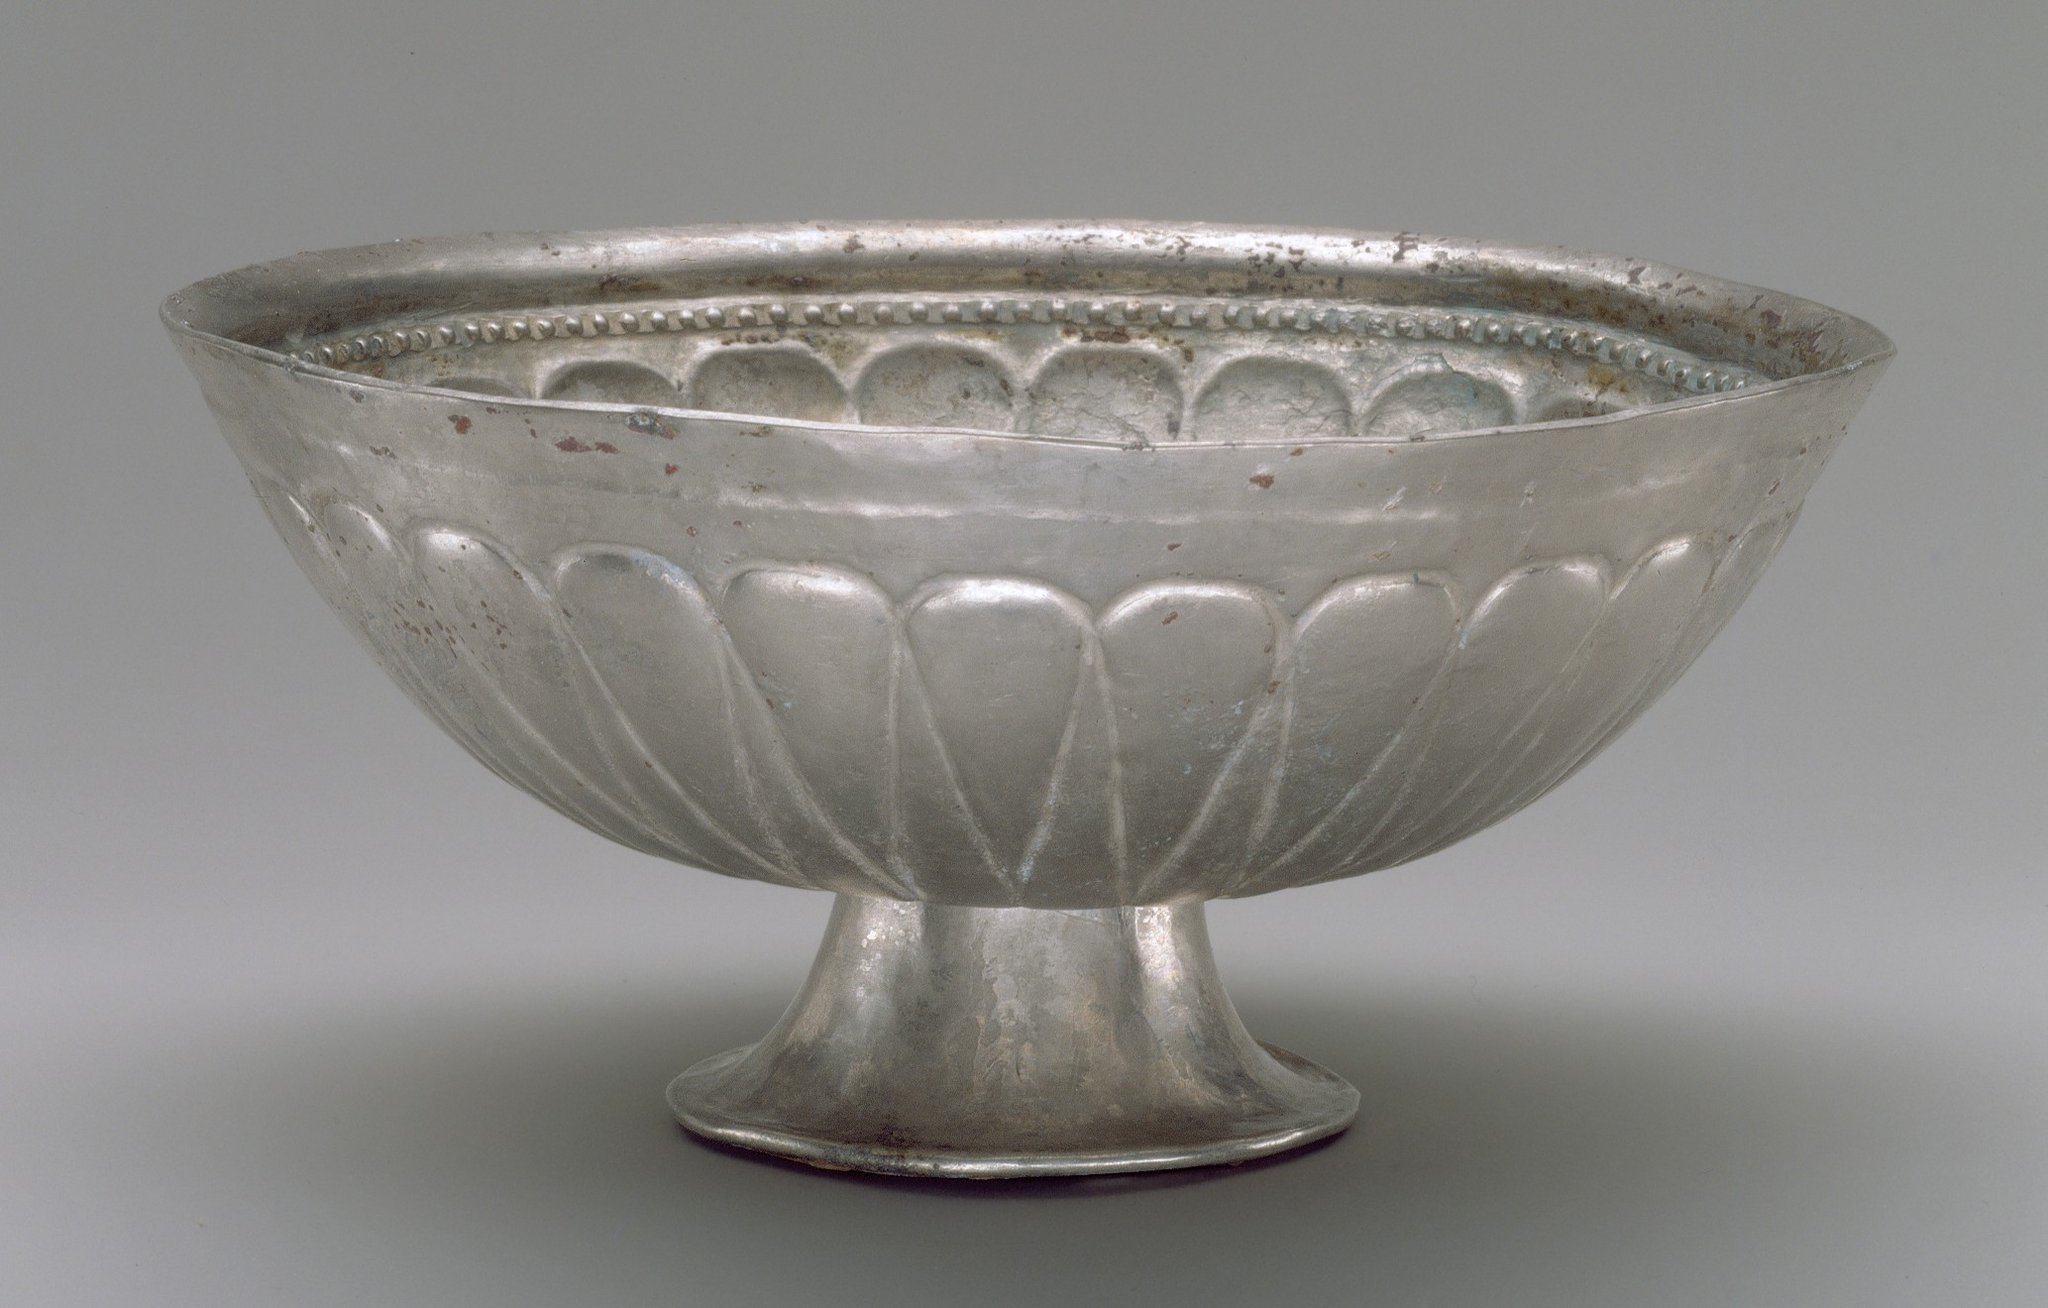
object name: cup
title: Footed Cup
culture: central asian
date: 501-600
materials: silver